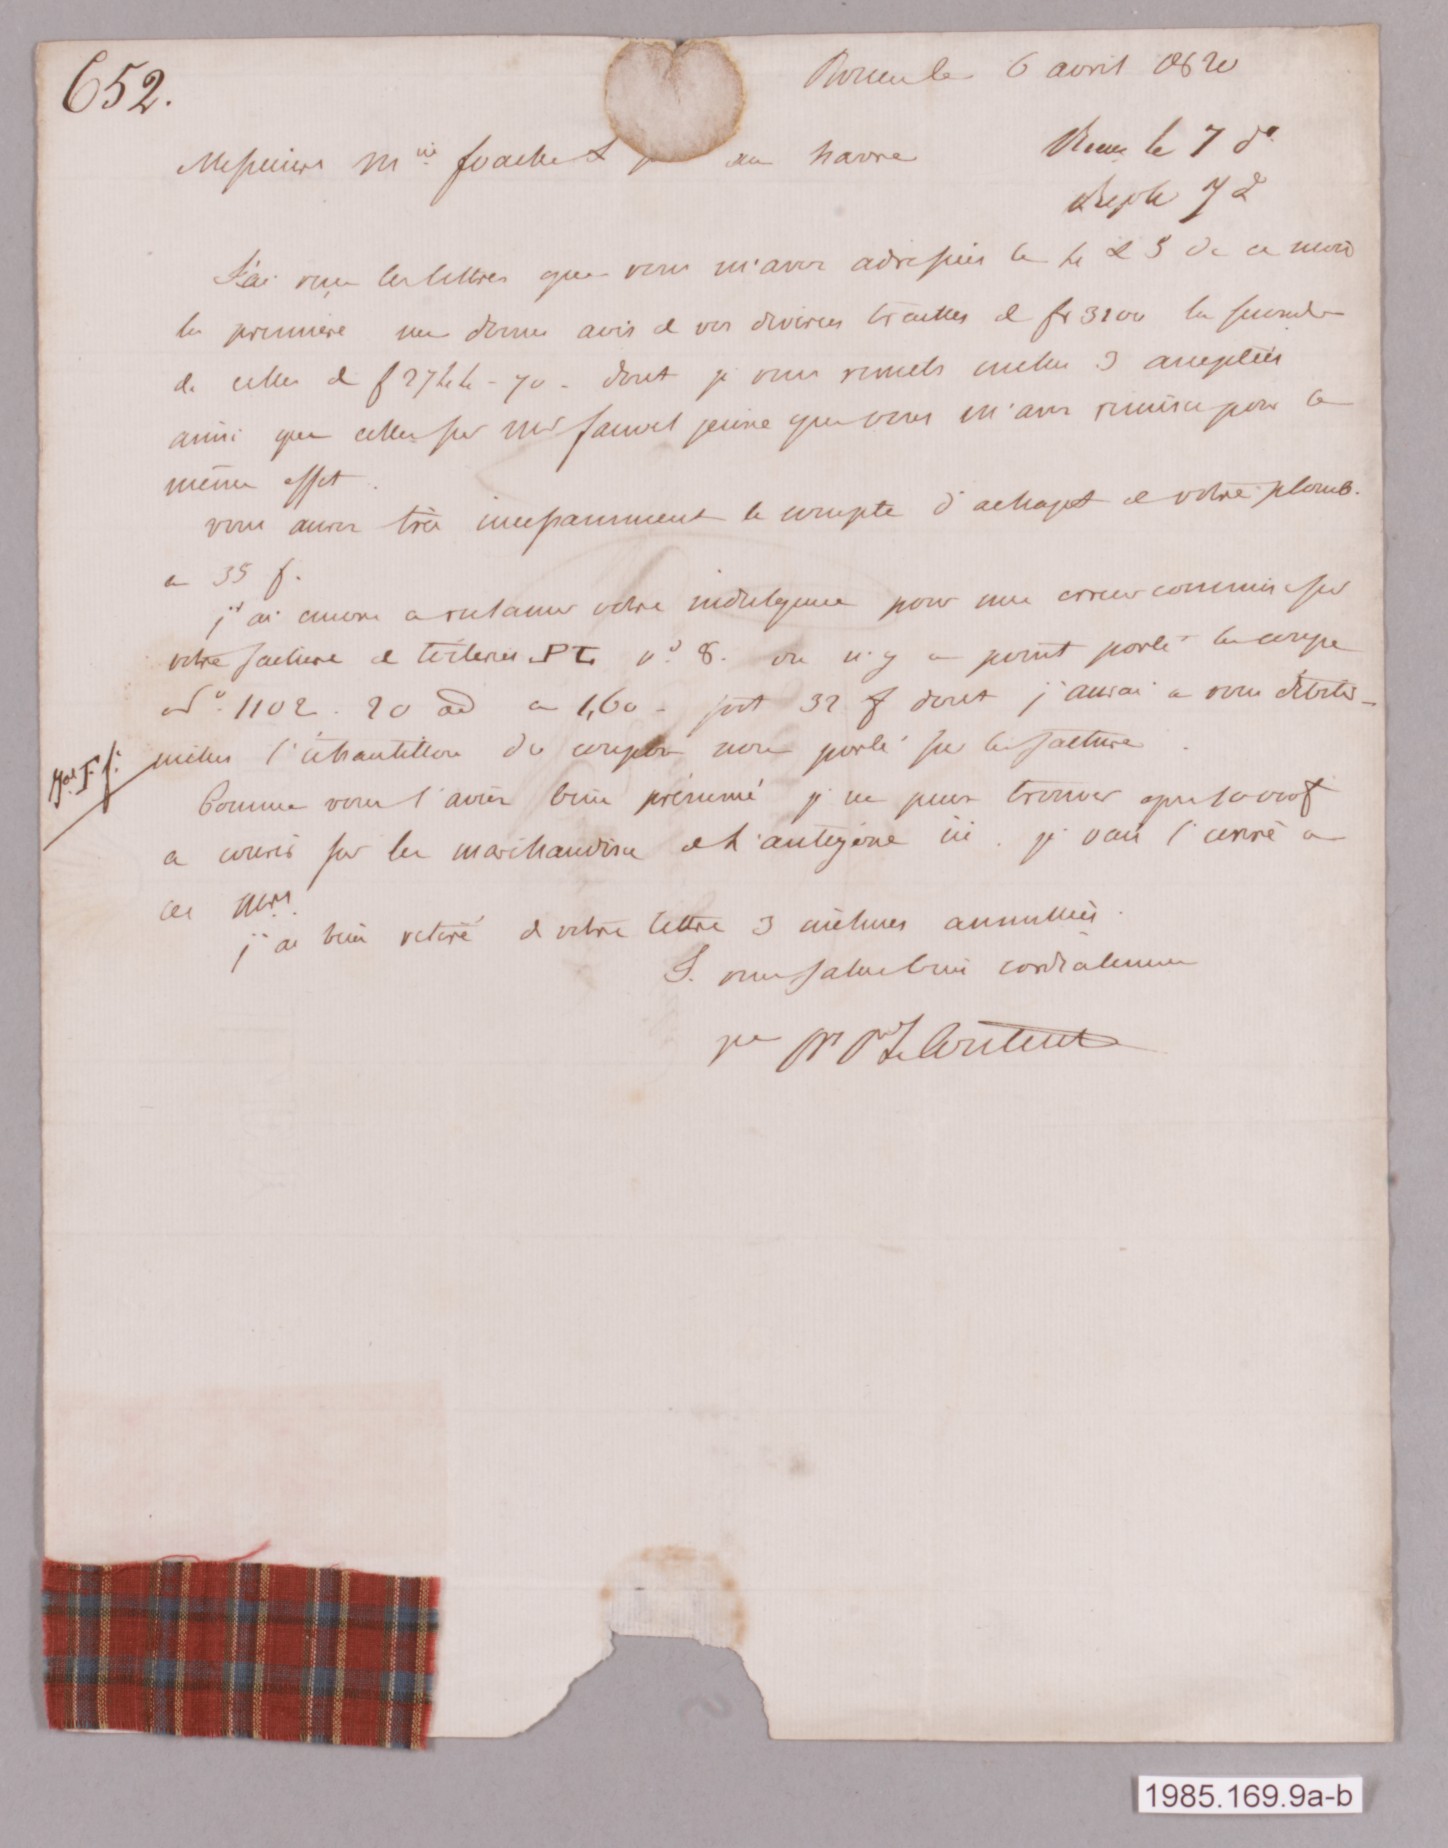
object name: letter with textile sample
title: Letter with textile samples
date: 1767-1833